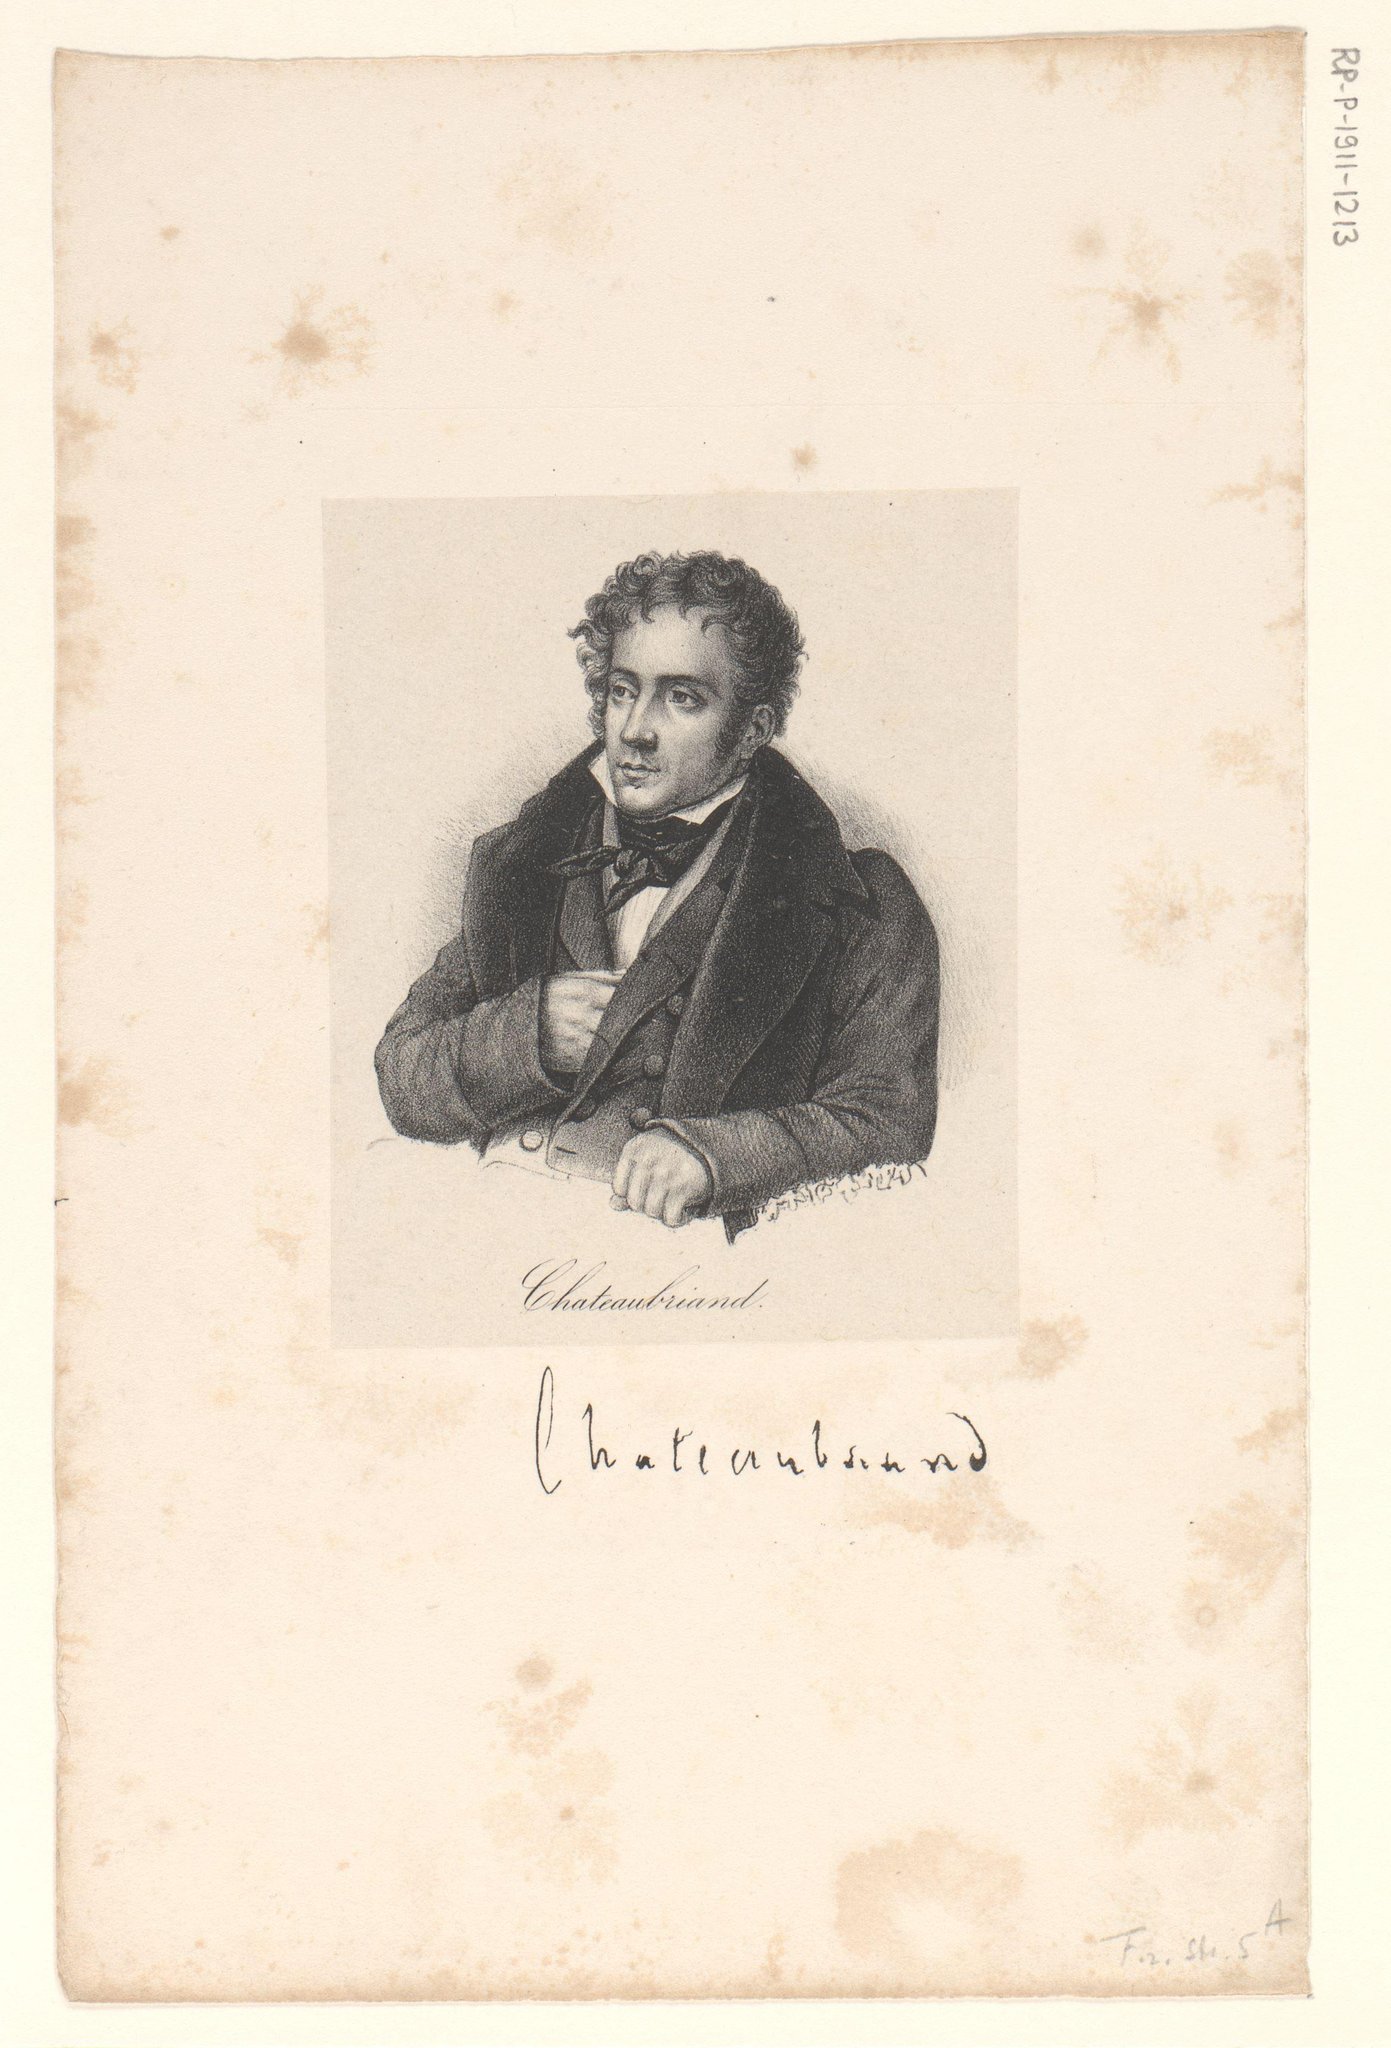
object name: print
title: Chateaubriand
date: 1818-1842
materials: paper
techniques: lithograph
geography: paris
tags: paris, politician, françois-rené de chateaubriand, historical persons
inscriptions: collector's mark: Lugt 2228a